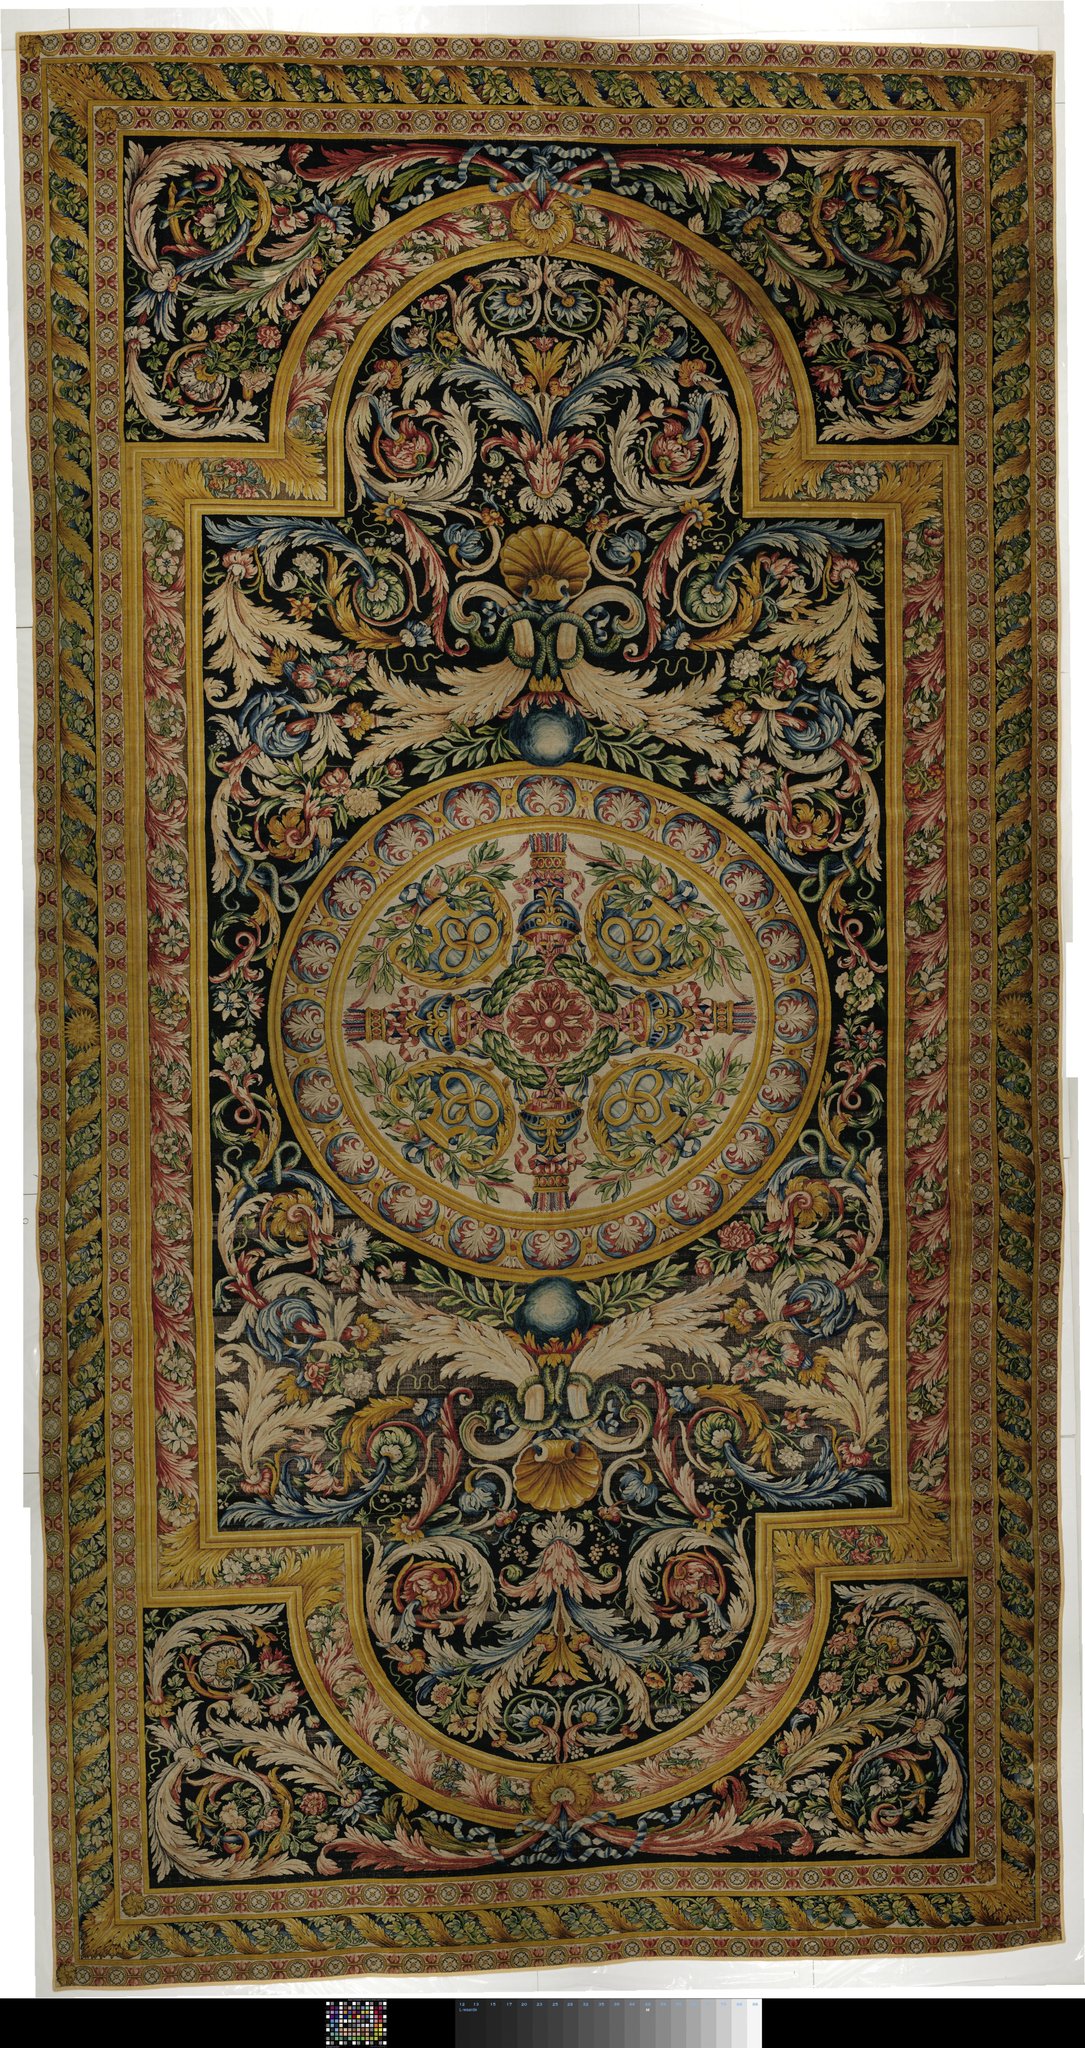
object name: tapijt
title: Savonnerietapijt met medaillon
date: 1665-1670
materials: wool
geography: paris